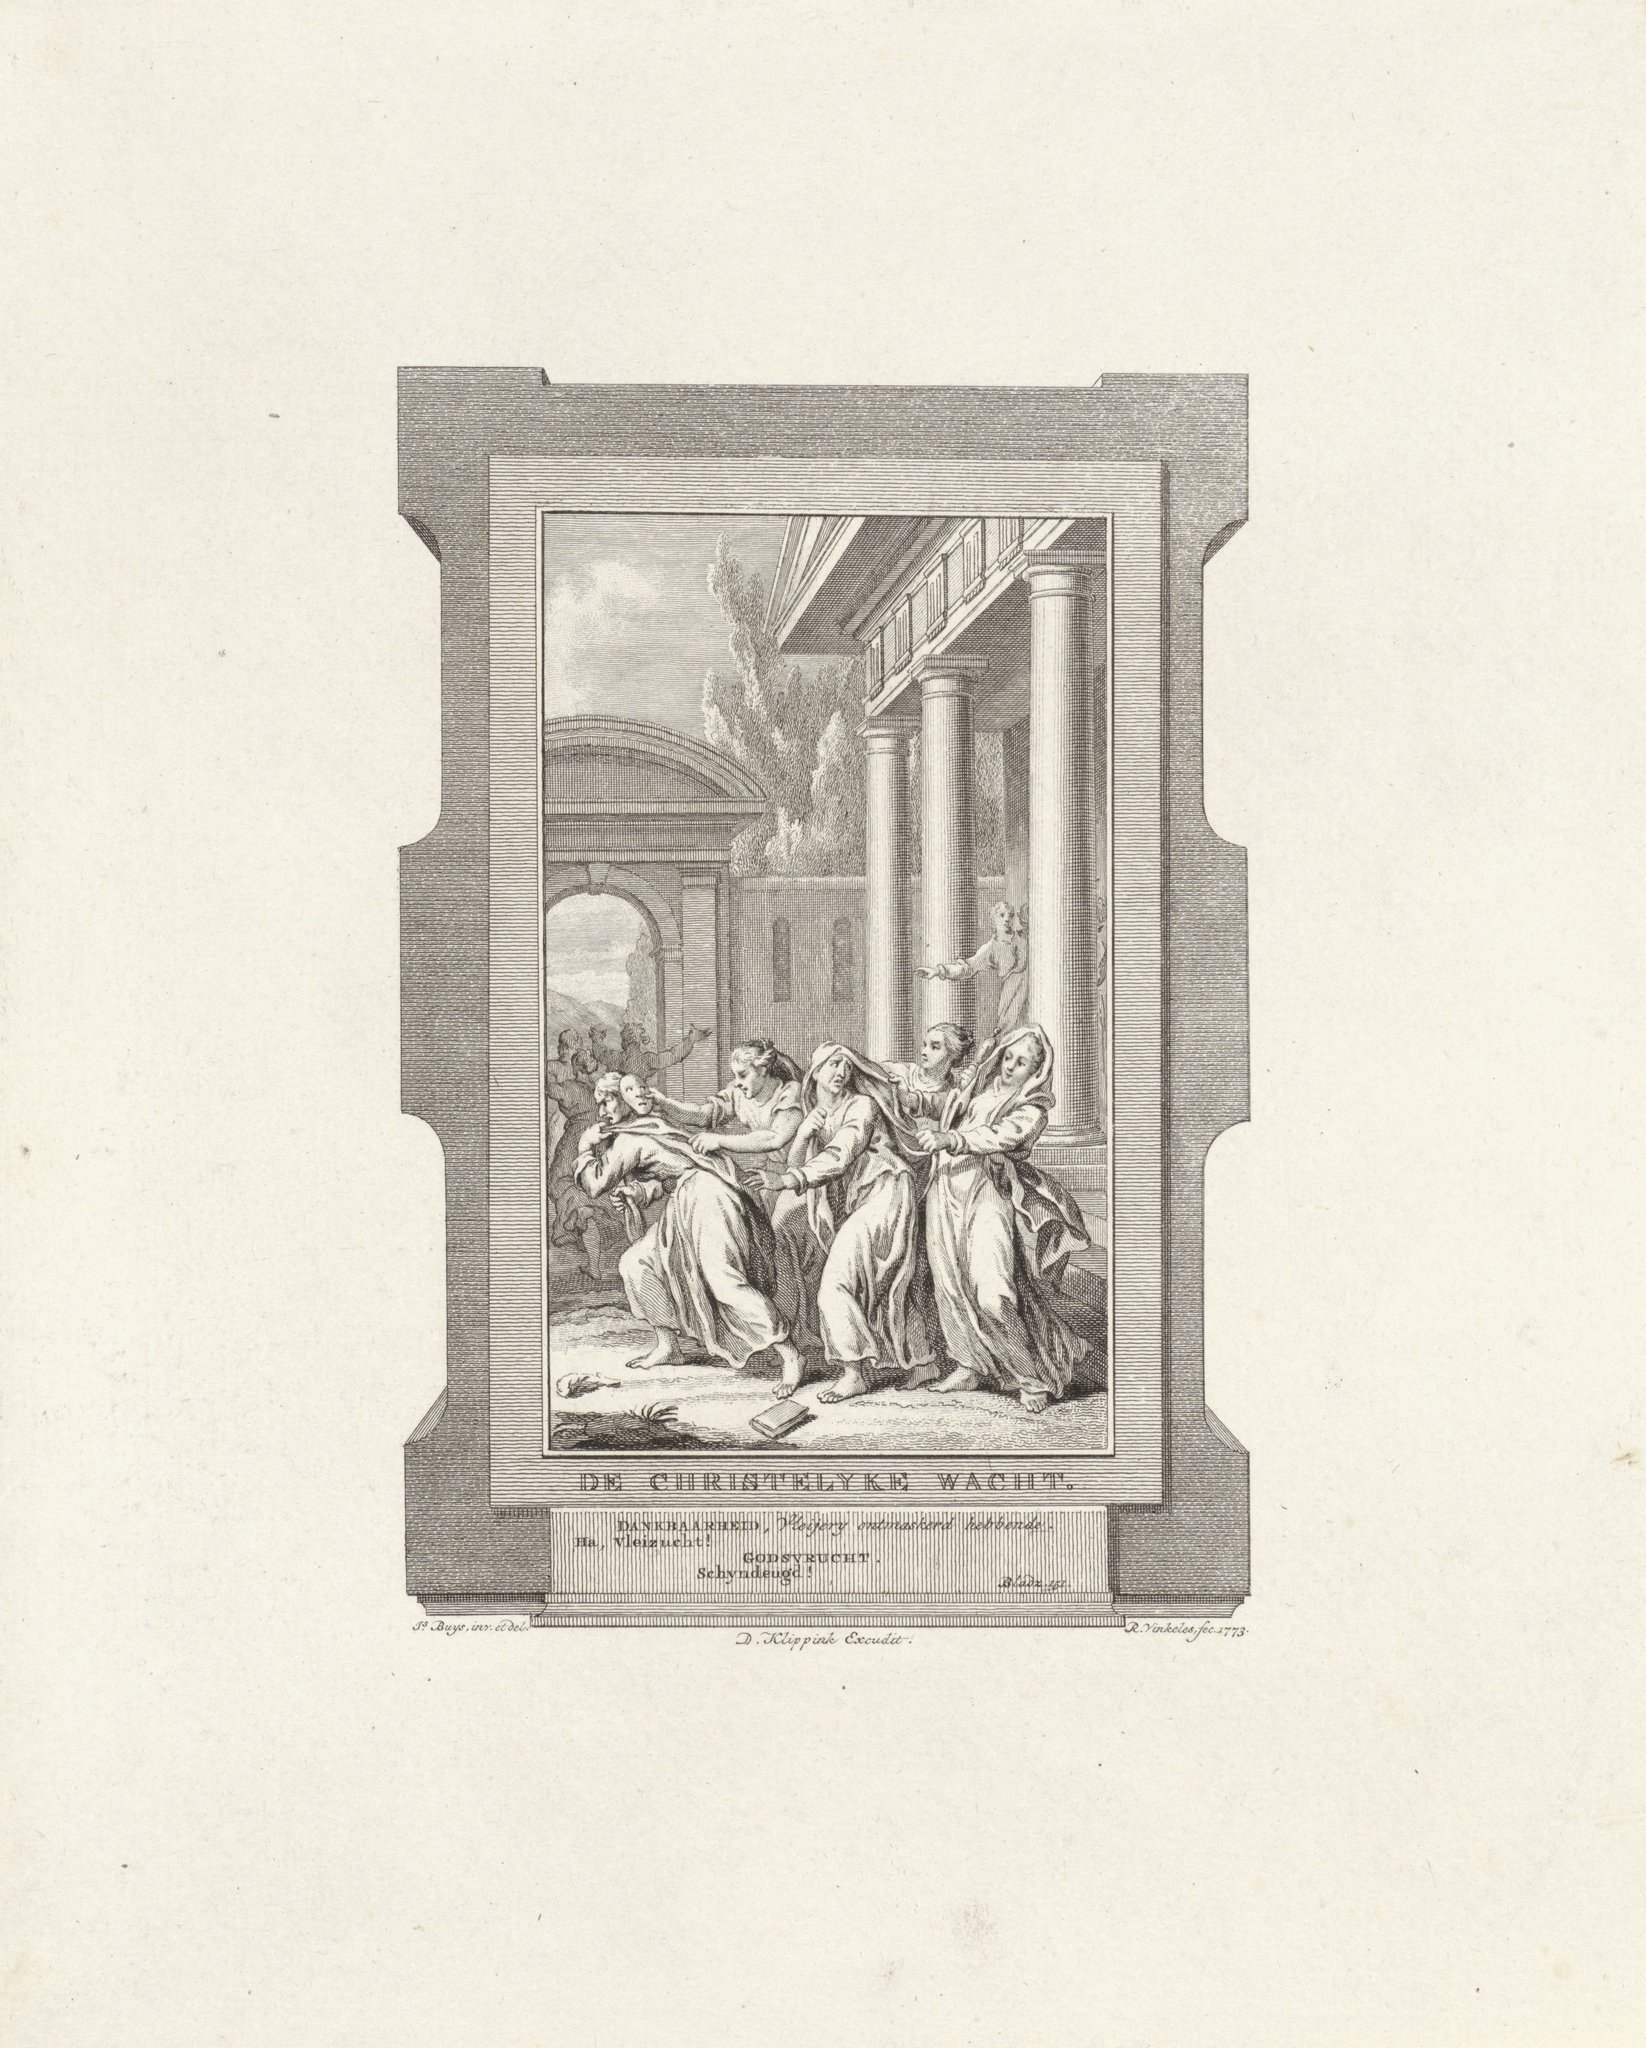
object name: print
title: Dankbaarheid ontmaskert Vleierij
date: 1751-1816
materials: paper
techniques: engraving, etching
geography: amsterdam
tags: flattery; 'adulatione' (ripa), disguise, gratitude; 'gratitudine', 'memoria grata de beneficii ricevuti' (ripa)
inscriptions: collector's mark: Lugt 240